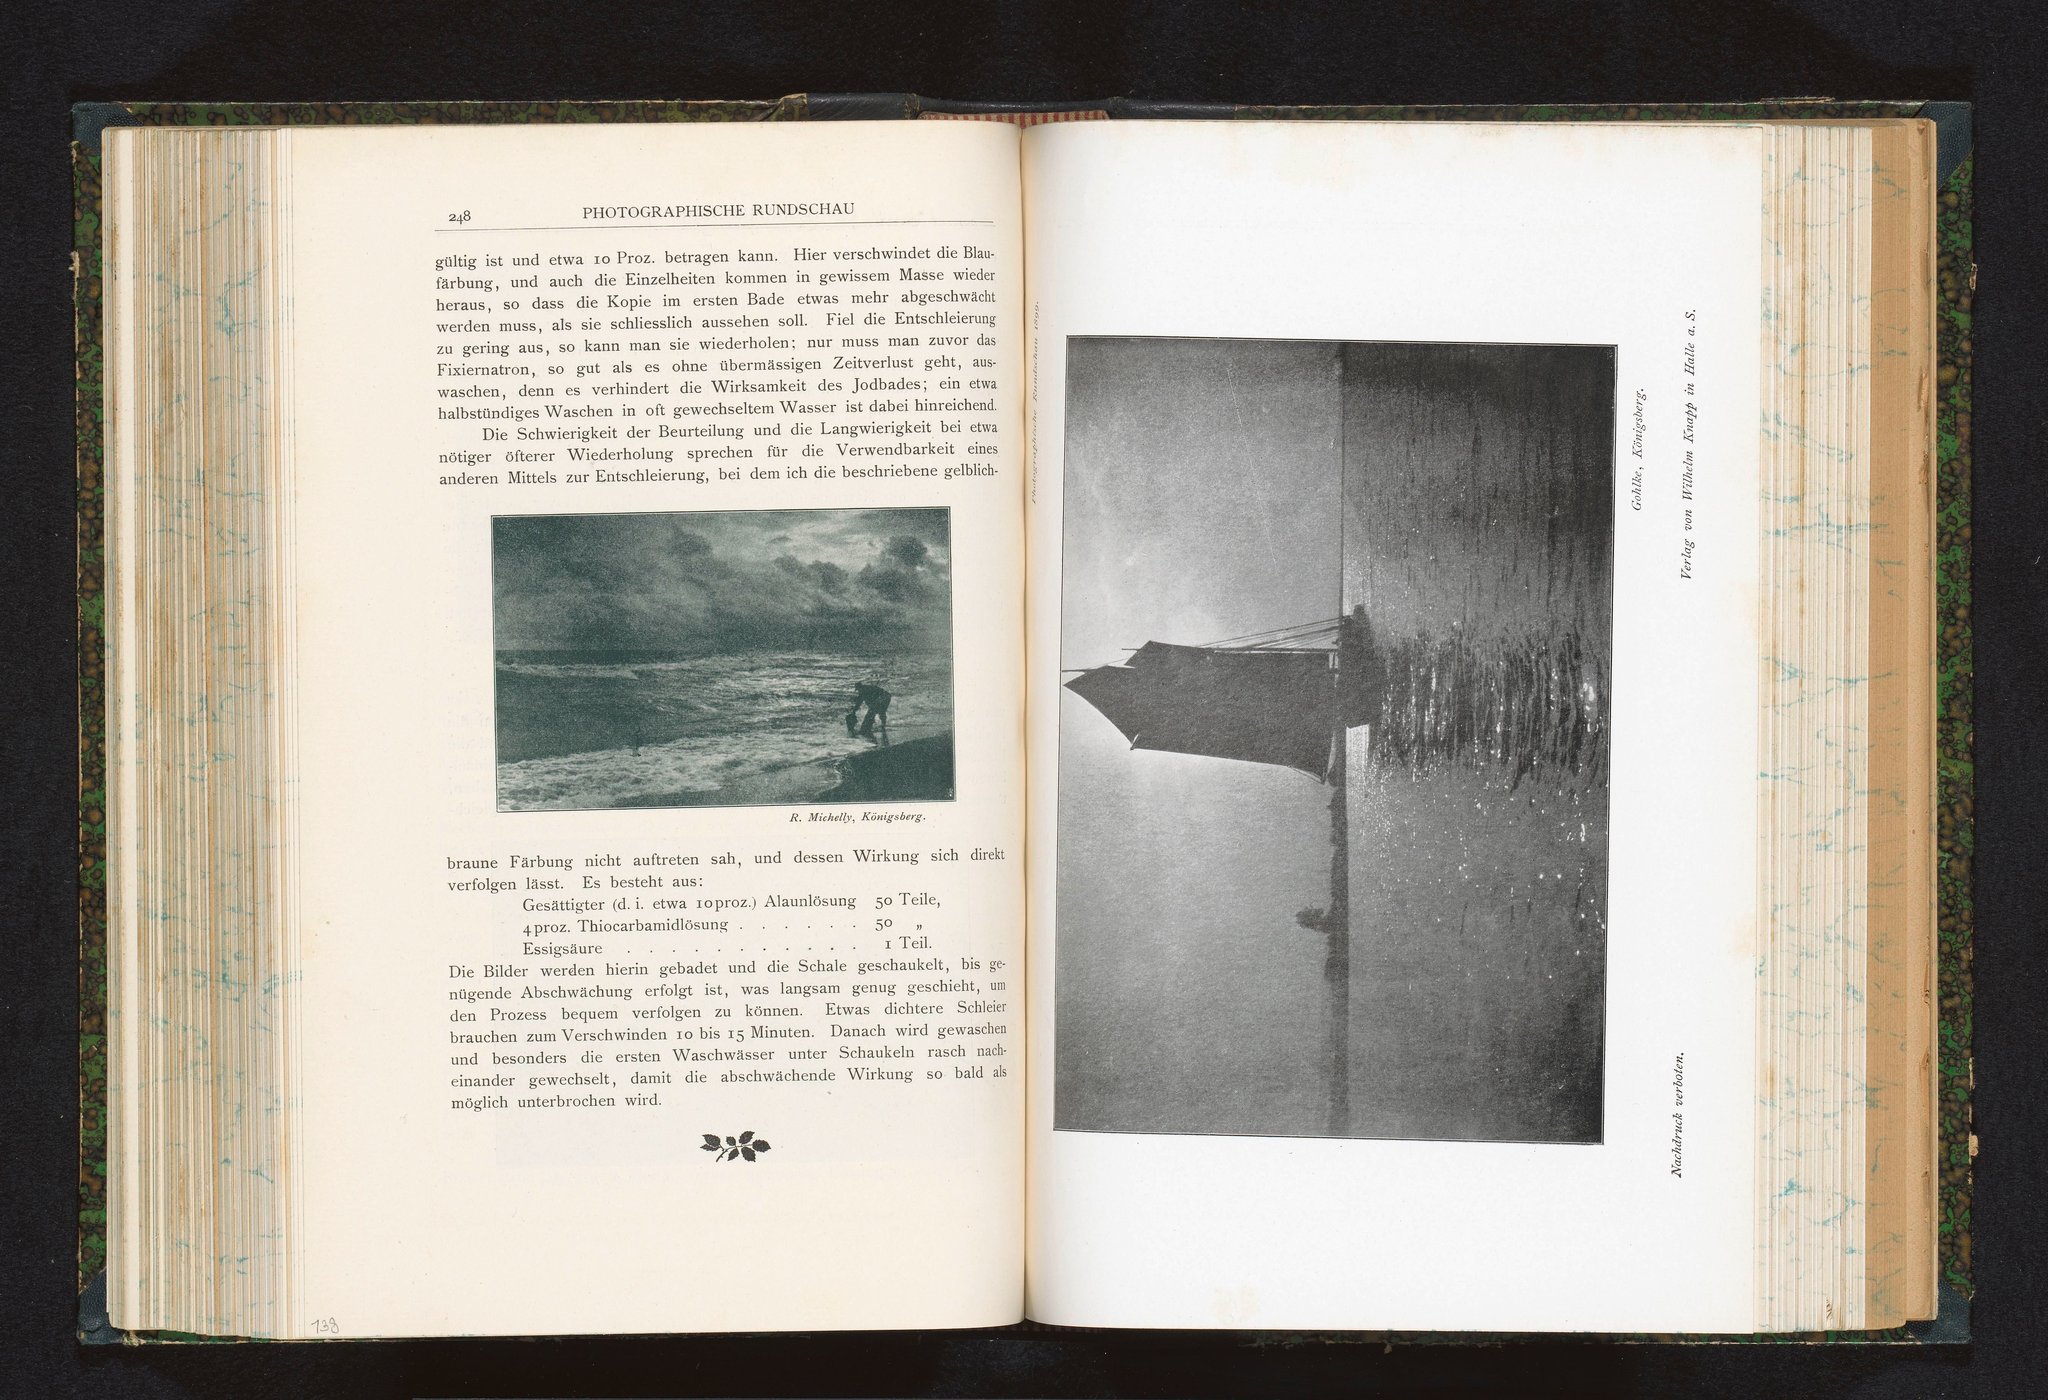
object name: page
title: Man staat voorovergebogen in de branding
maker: r. michelly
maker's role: fotograaf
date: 1894-1899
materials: paper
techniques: autotype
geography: berlin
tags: adult man, sea (seascape), surf, breakers